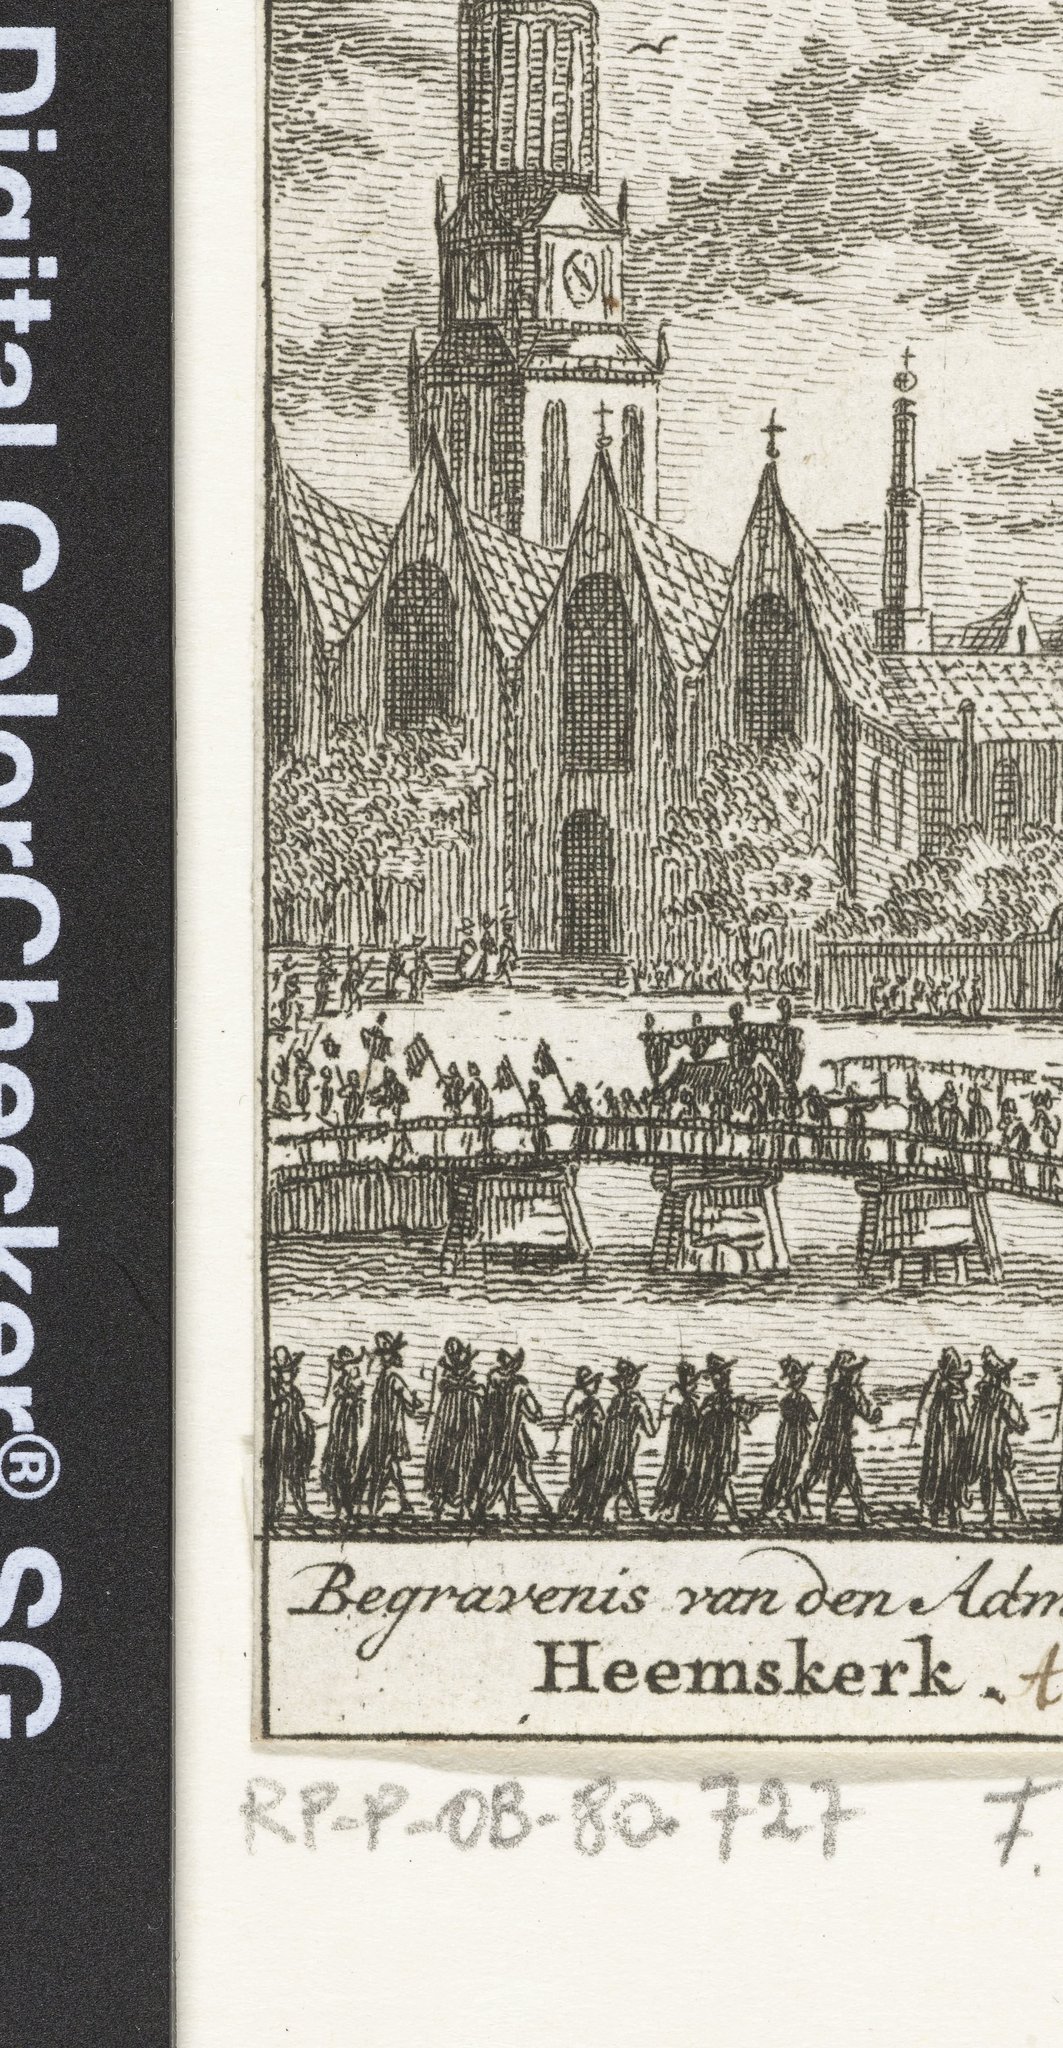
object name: print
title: Begrafenis van Jacob van Heemskerck in de Oude Kerk te Amsterdam, 1607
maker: simon fokke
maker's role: draughtsman, print maker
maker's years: 1712-1784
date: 1722-1784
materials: paper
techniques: etching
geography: northern netherlands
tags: jacob van heemskerck, cortege, funeral procession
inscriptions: inscription: ‘Ao. 1607’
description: Begrafenis van Jacob van Heemskerck in de Oude Kerk te Amsterdam, 8 juni 1607. De begrafenisoptocht trekt langs de gracht naar de Oude Kerk.